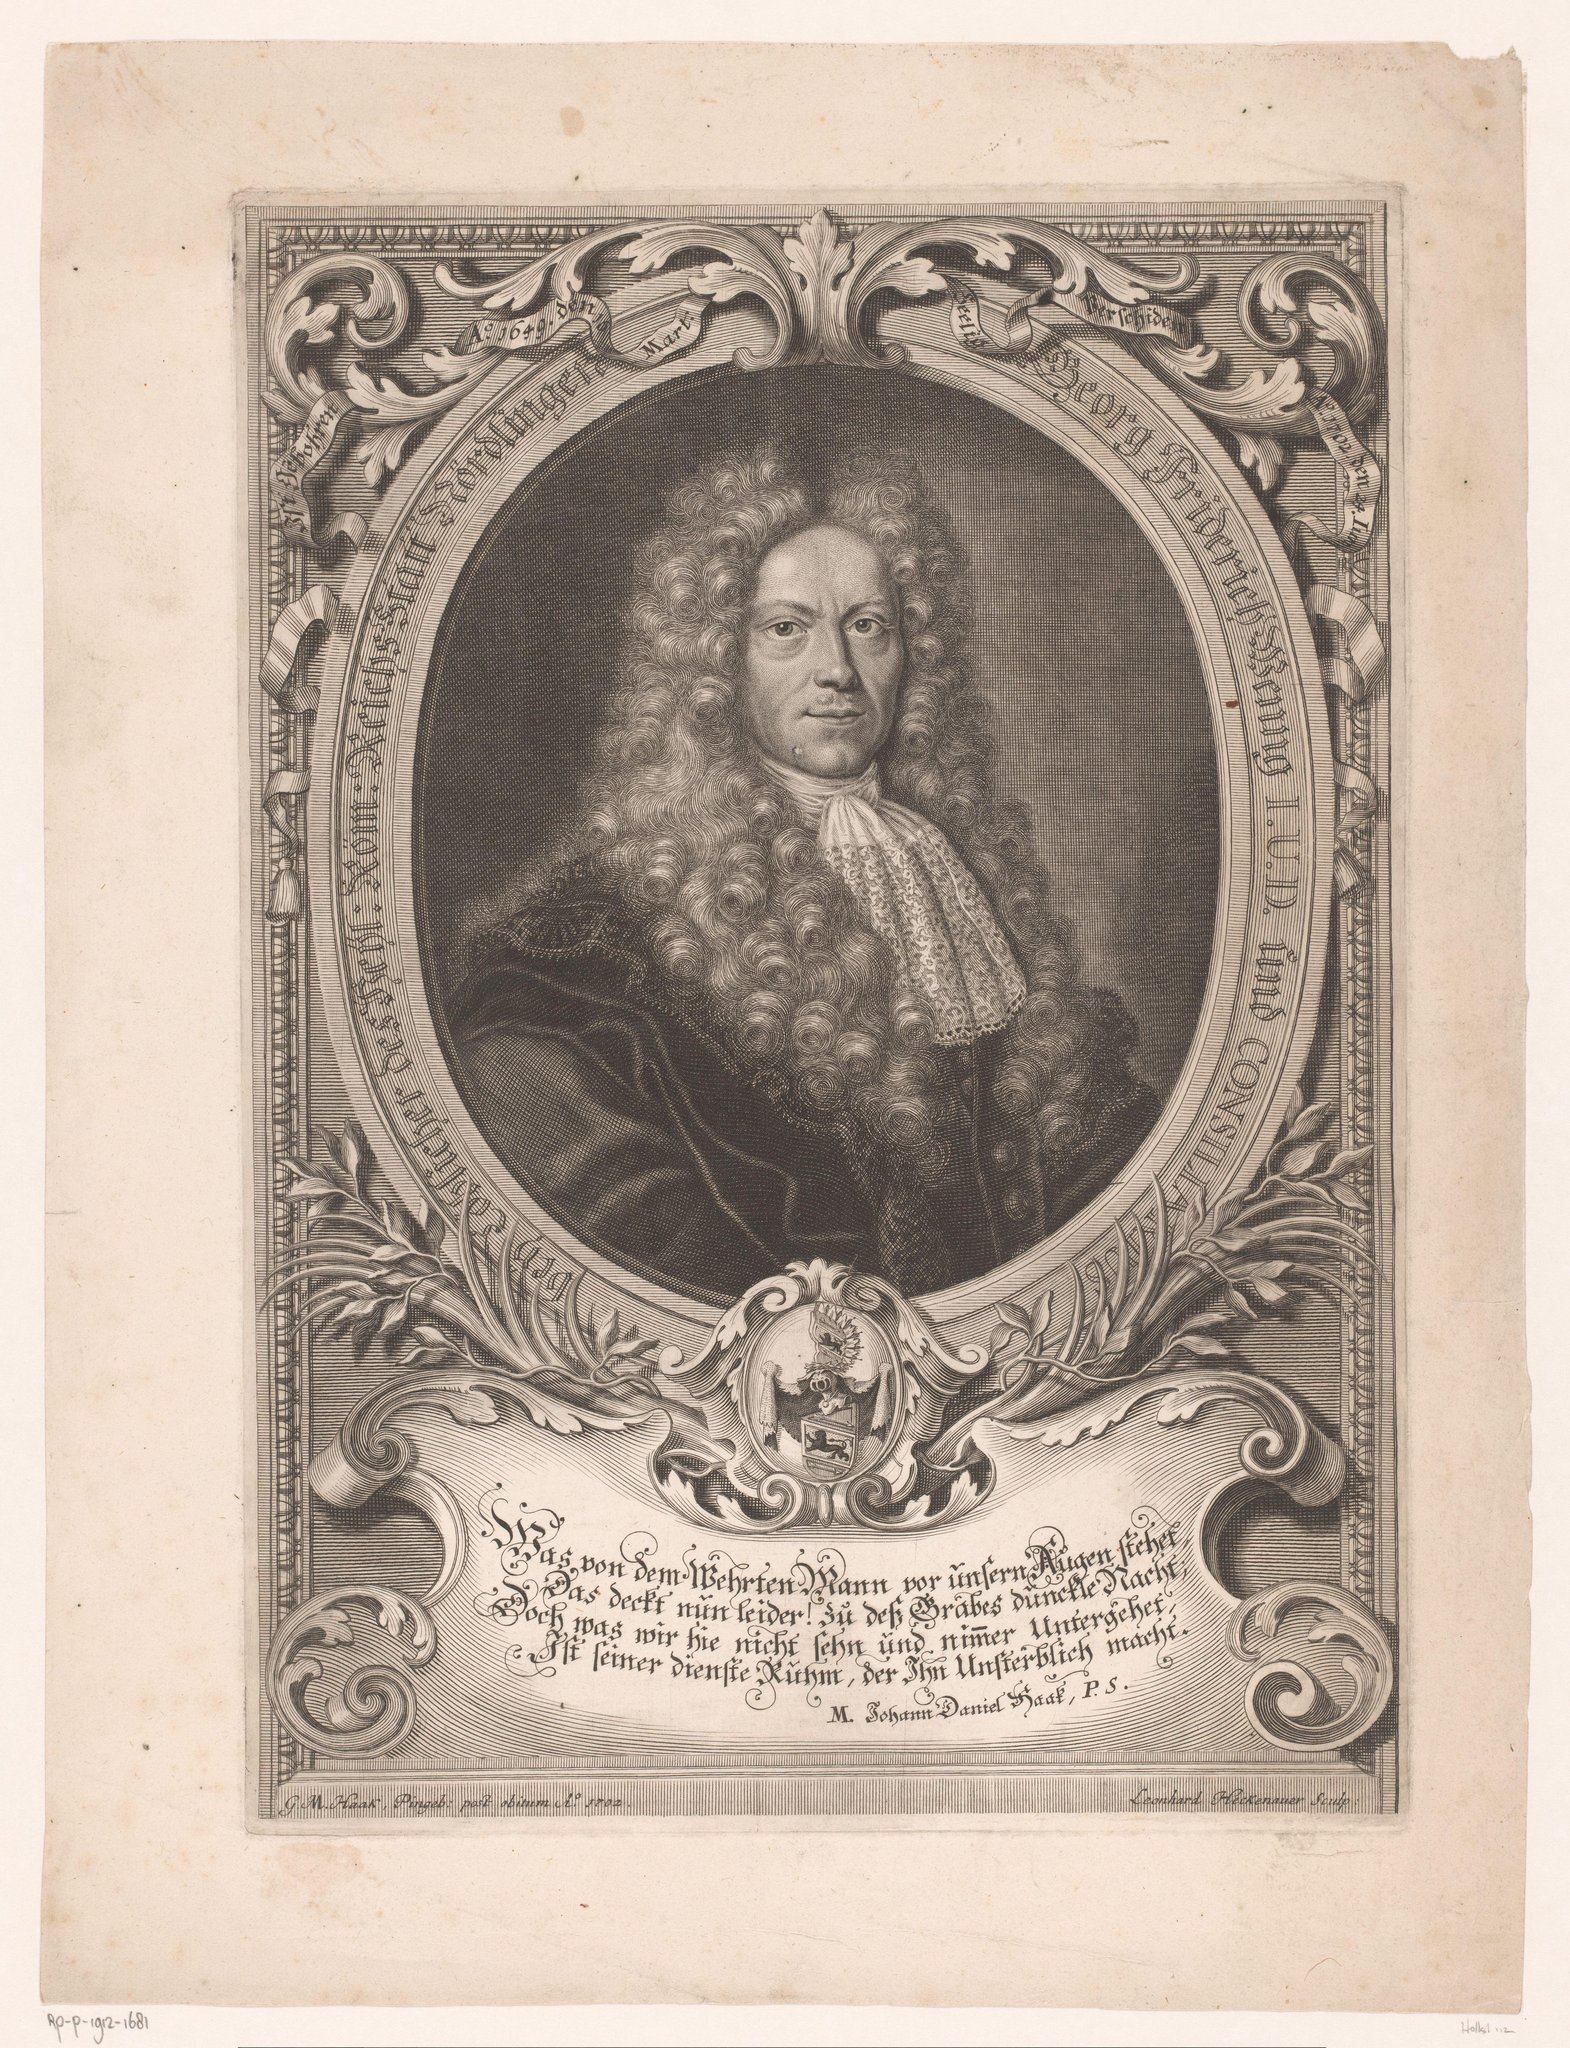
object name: print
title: Portret van Georg Friedrich Weng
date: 1702-1704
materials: paper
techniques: engraving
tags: trees: laurel (branch, stick), trees: palm-tree (+ branch, stick), historical persons, armorial bearing, heraldry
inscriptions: collector's mark: Lugt 2228